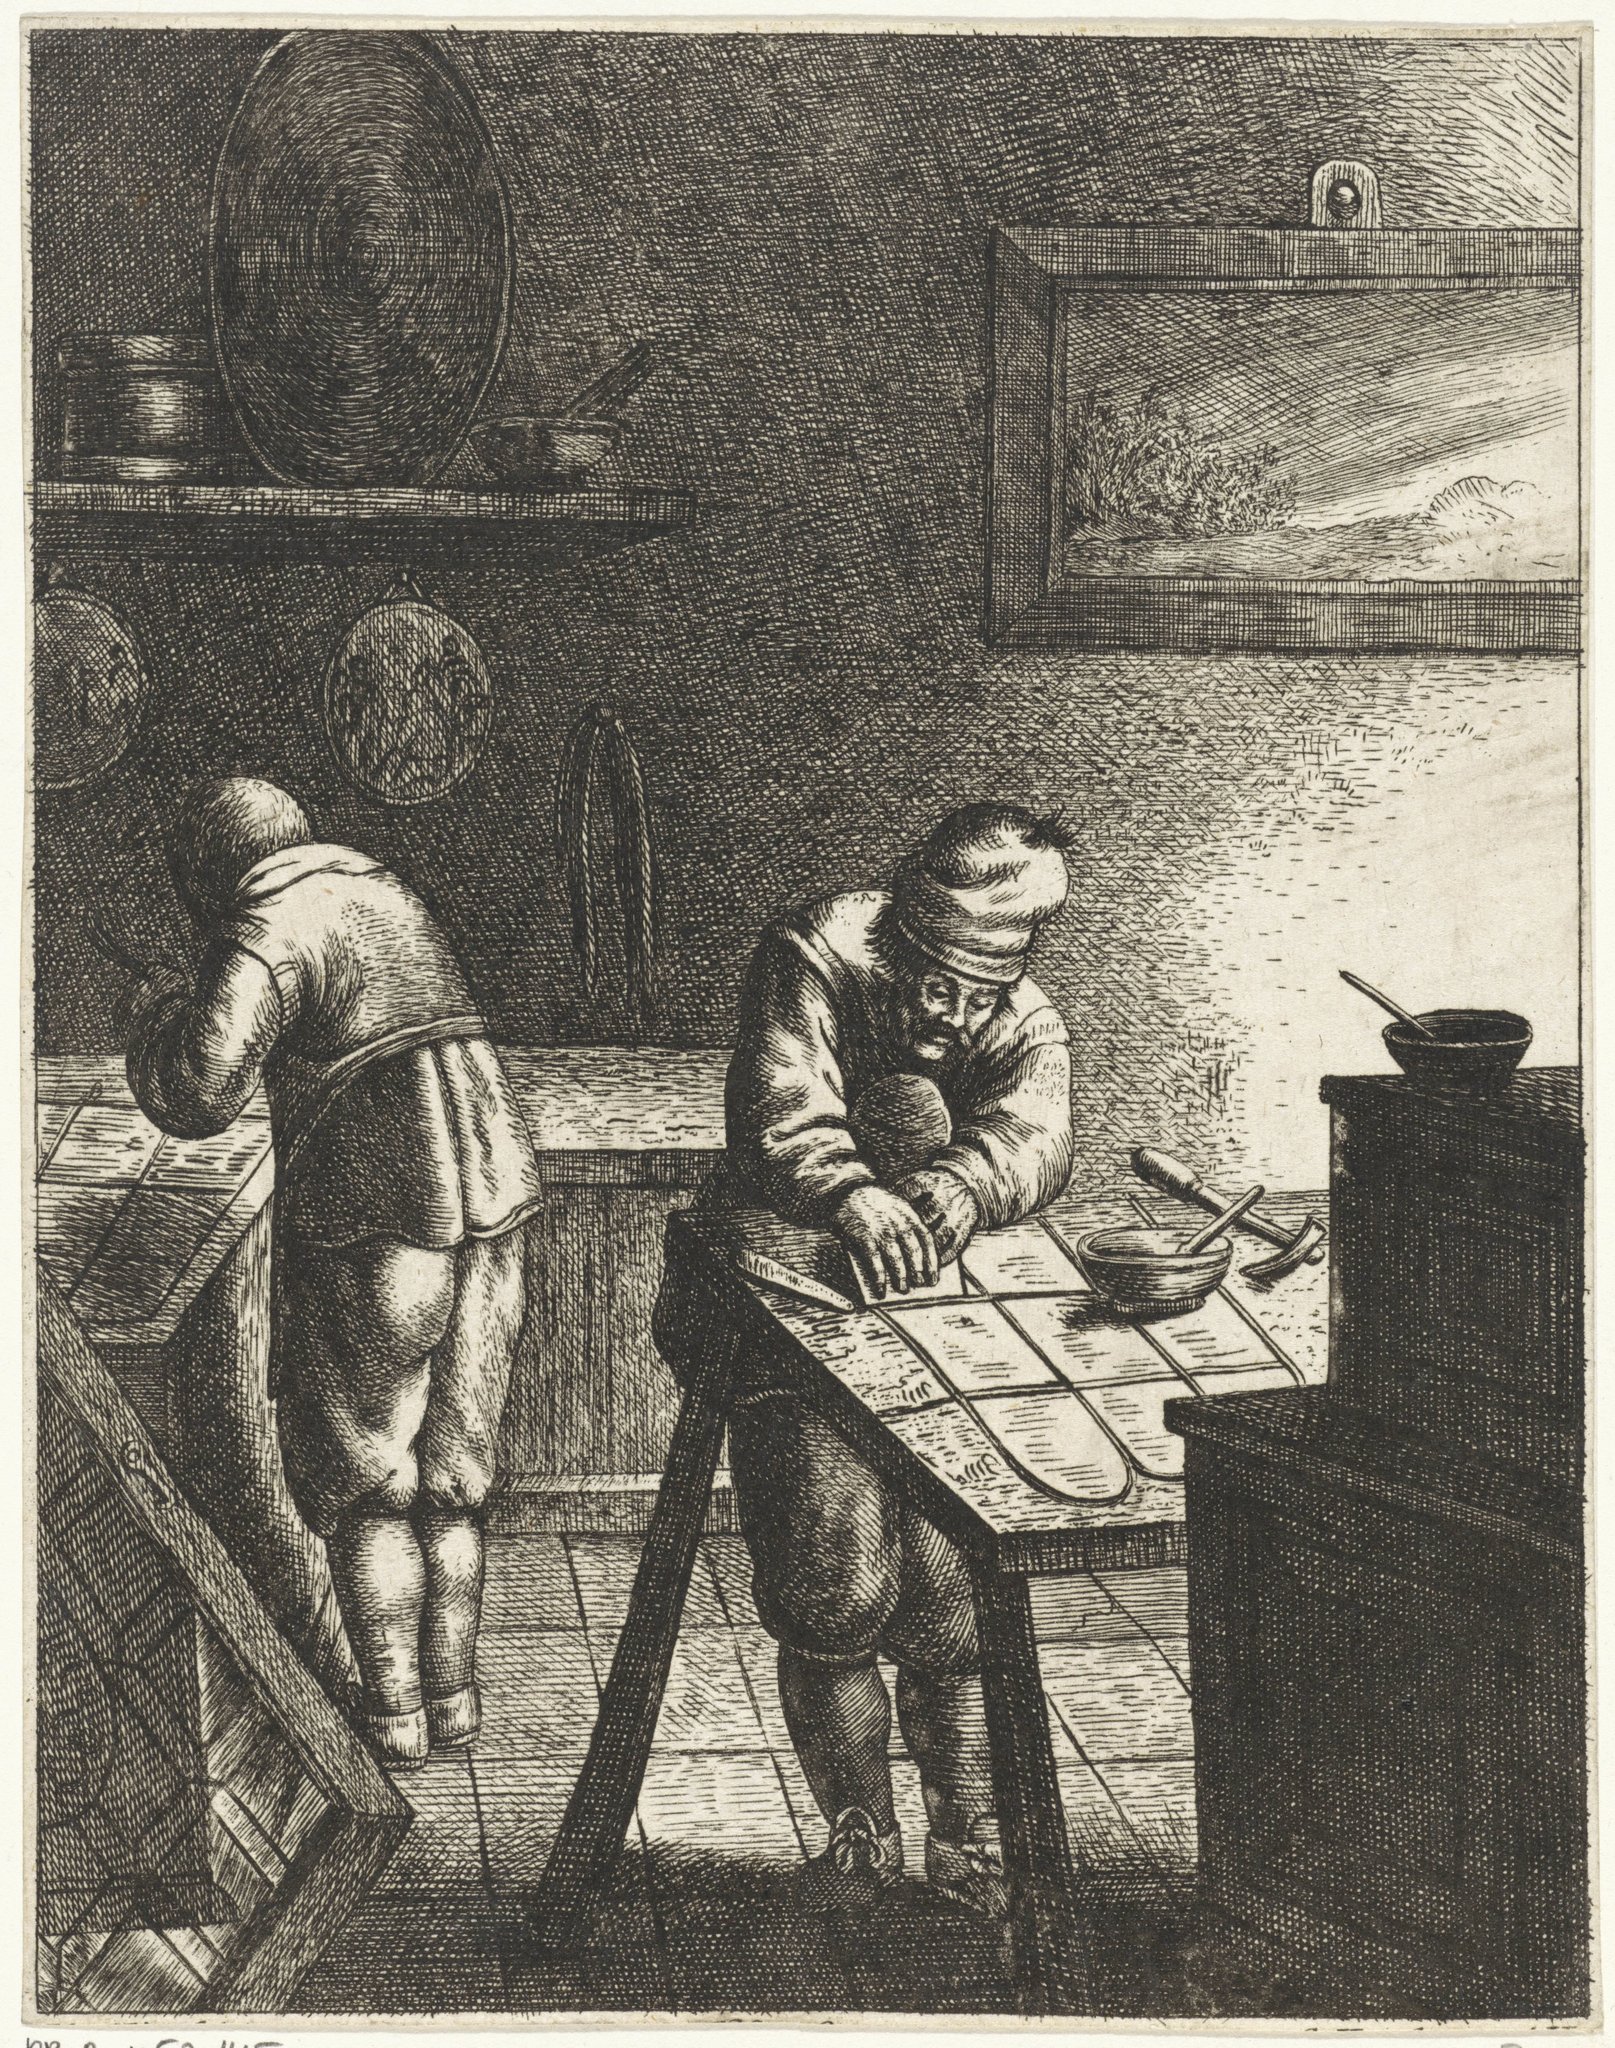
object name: print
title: Glazenier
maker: Anonymous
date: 1635-1685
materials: paper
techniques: engraving, etching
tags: glass-maker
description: Kopie naar de prent uit de serie 'Beroepen' van Jan Gillisz. van Vliet.